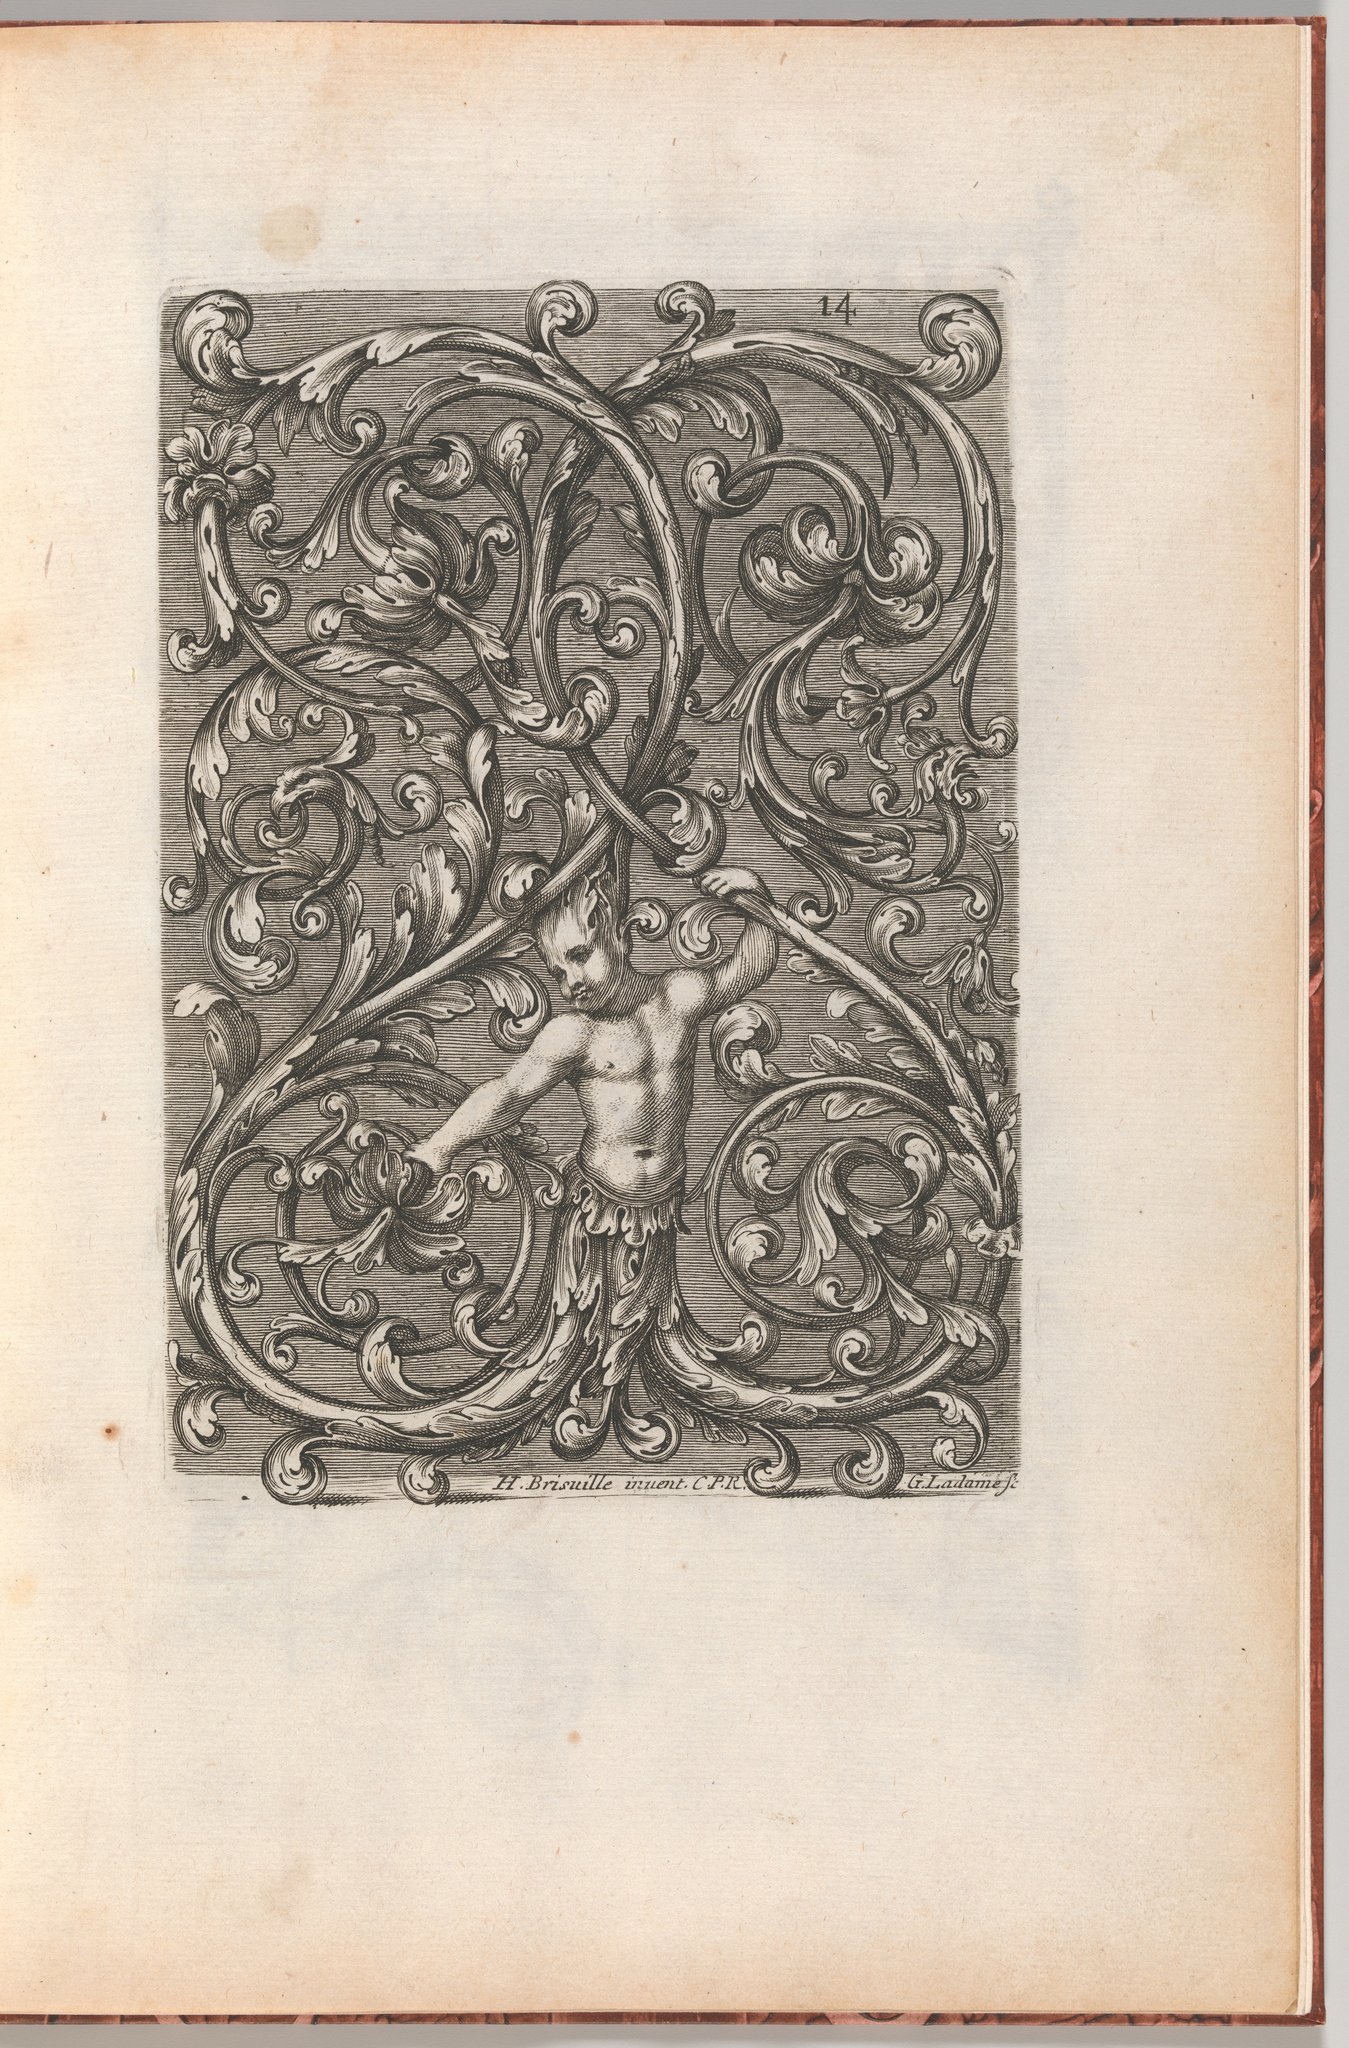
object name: album print ornament architecture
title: Diverses Pieces de Serruriers, page 15 (recto)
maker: jean berain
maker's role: artist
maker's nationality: french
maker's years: 1640-1711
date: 1663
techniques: engraving